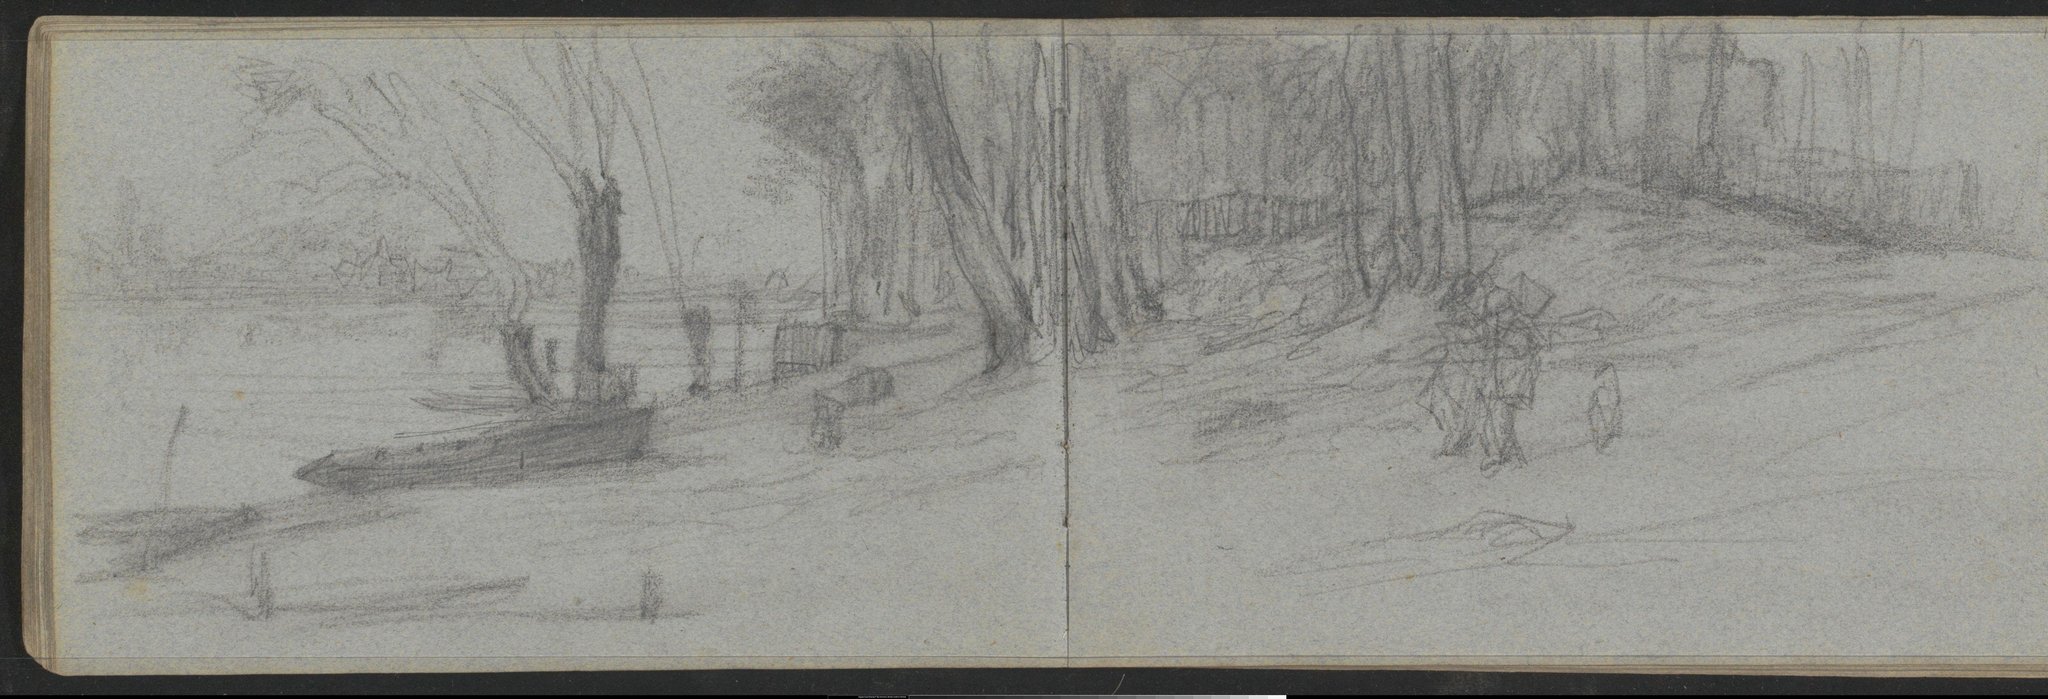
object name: sketchbook leaf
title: Landschap met figuren en bomen bij een waterkant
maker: matthijs maris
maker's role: draughtsman, painter, print maker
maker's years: 1839-1917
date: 1849-1917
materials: paper, pencil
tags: rowing-boat, canoe, etc., landscapes with waters, waterscapes, seascapes (in the temperate zone) (+ landscape with figures, staffage)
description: Aan de waterkant liggen roeiboten aangemeerd. Blad 16 verso en 17 recto uit een schetsboek met 35 bladen.